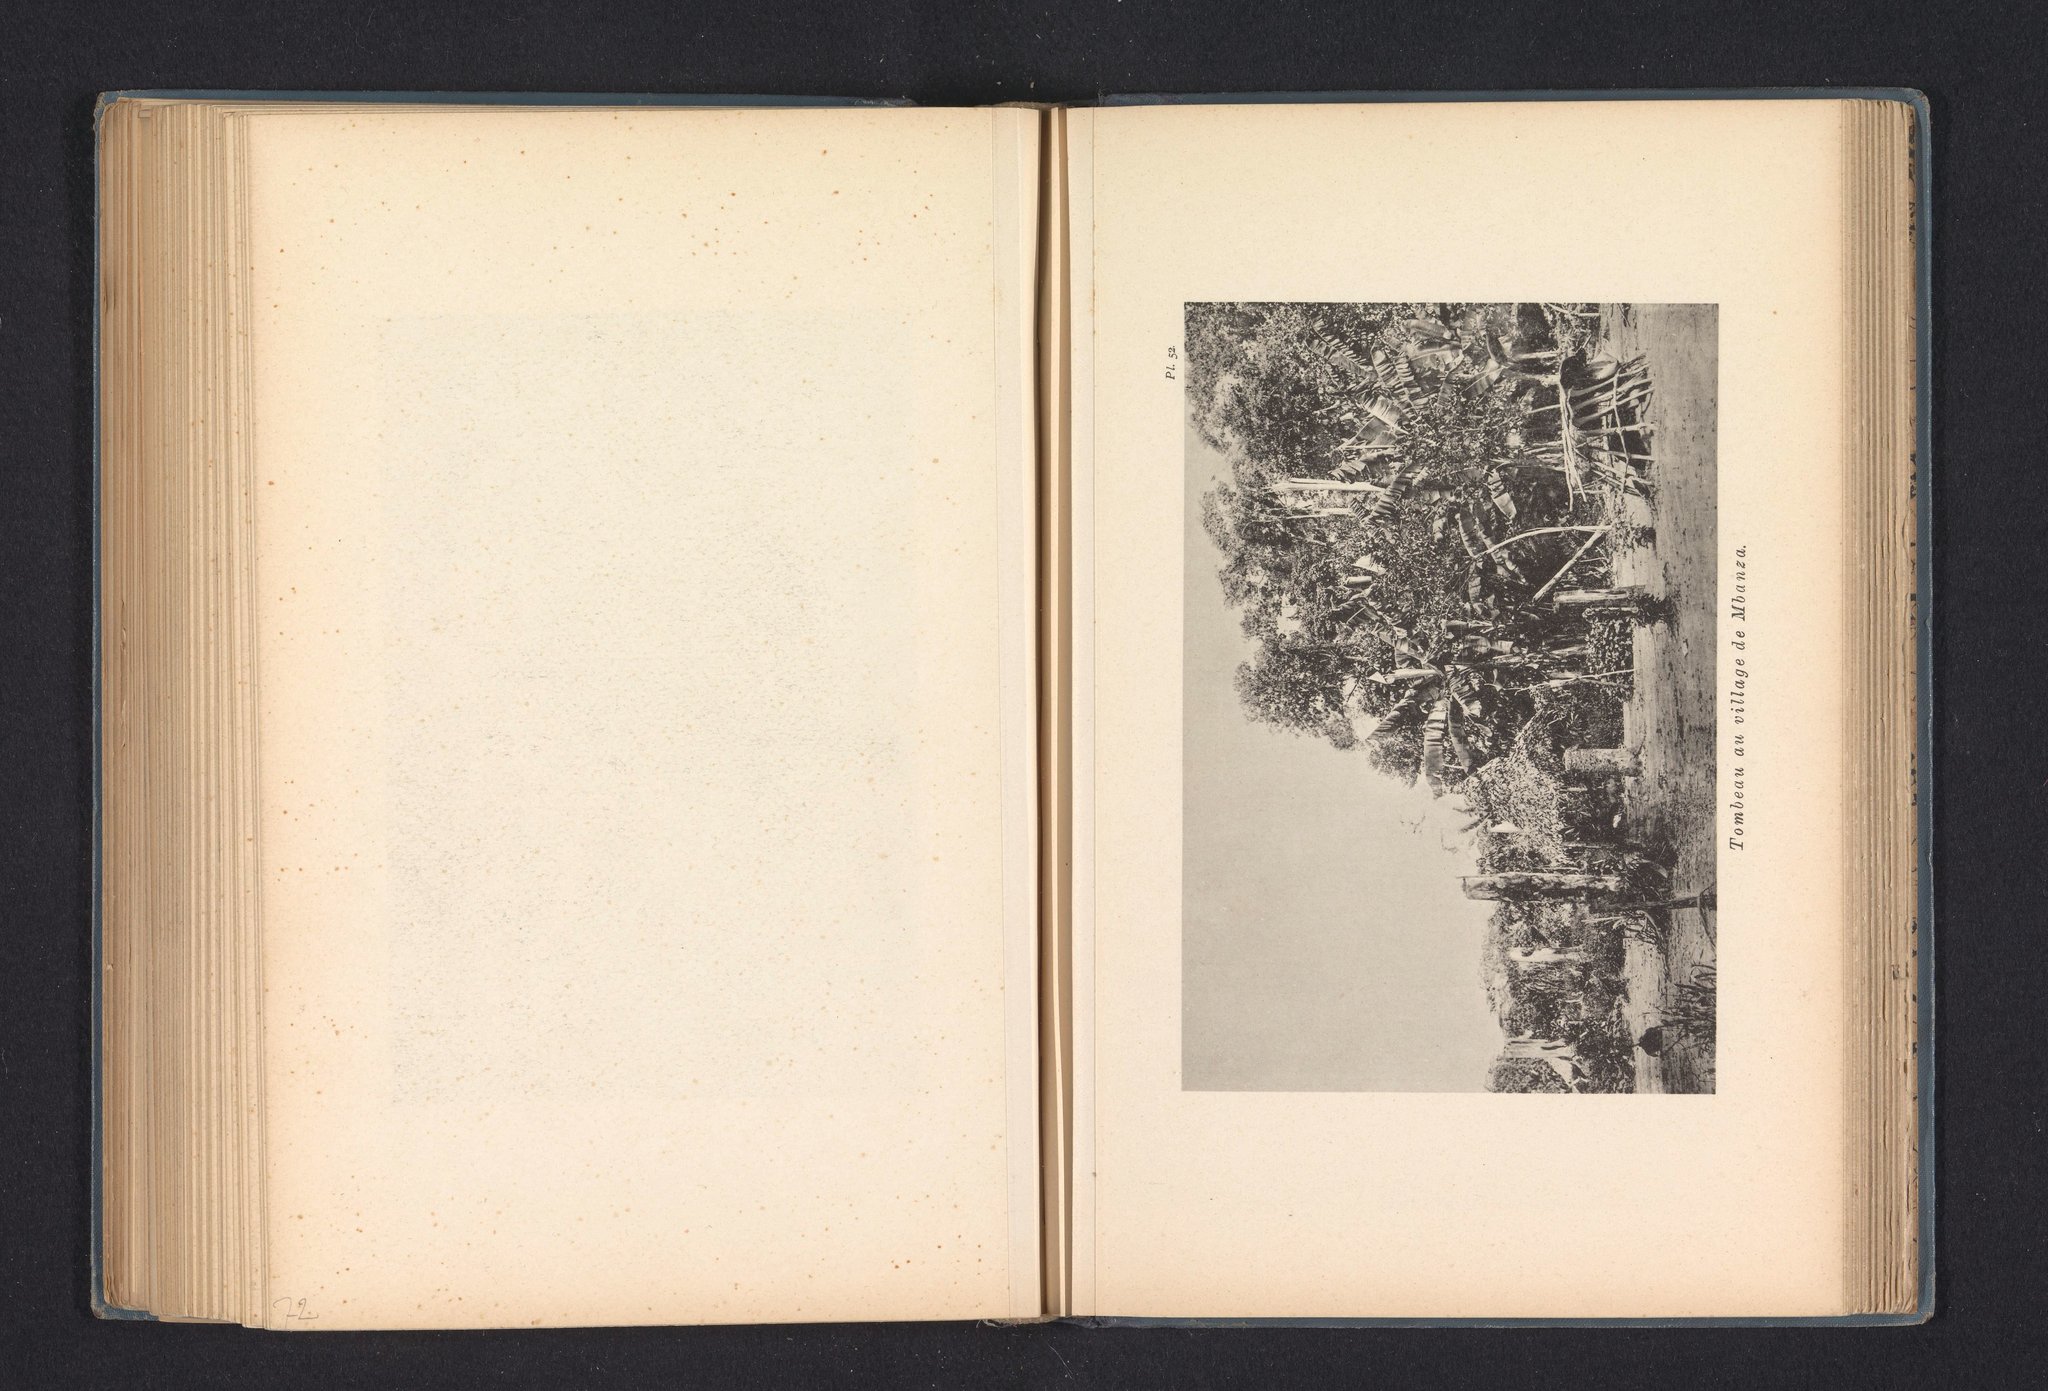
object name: page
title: Tombeau au village de Mbanza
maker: franz thonner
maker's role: botanicus, ontdekkingsreiziger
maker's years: 1863-1928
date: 1896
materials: paper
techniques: photograph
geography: m'banza congo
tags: grave, tomb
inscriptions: number: ‘Pl. 52.’